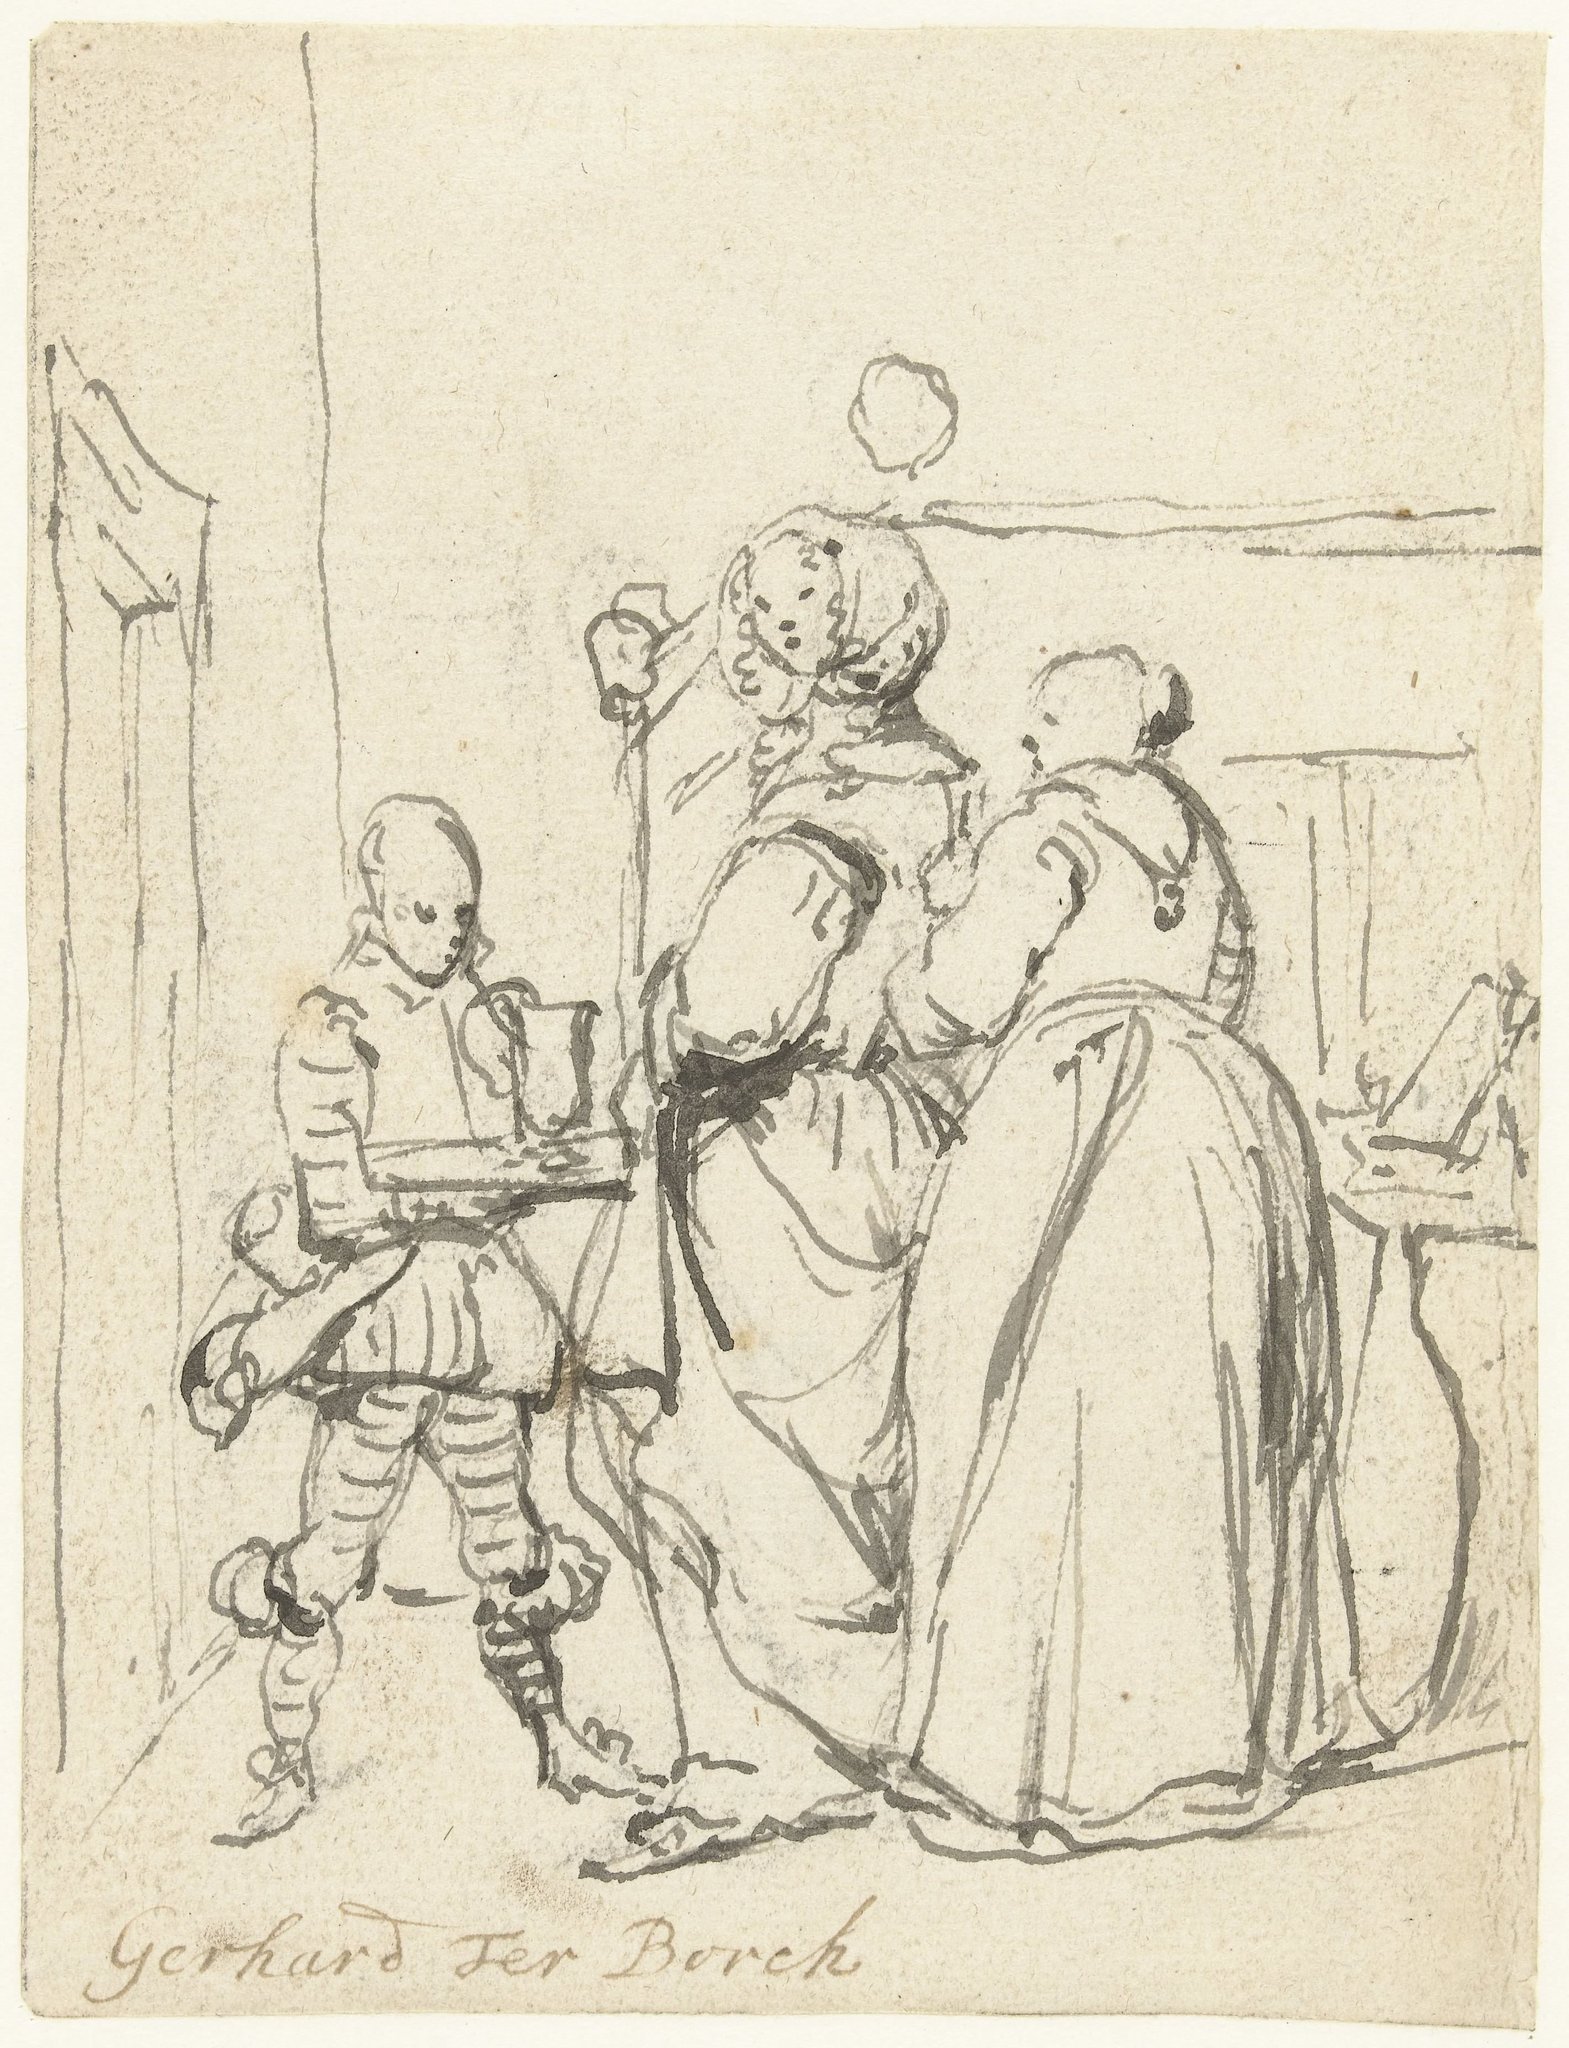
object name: drawing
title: Dame bezig met haar toilet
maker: gerard ter borch (ii)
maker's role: draughtsman, painter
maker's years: 1617-1681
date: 1659-1661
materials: chalk, ink, paper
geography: deventer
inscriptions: annotation: ‘Gerhard Ter Borch’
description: Een dame bezig met haar toilet, in het bijzijn van een kamermeisje en een page.